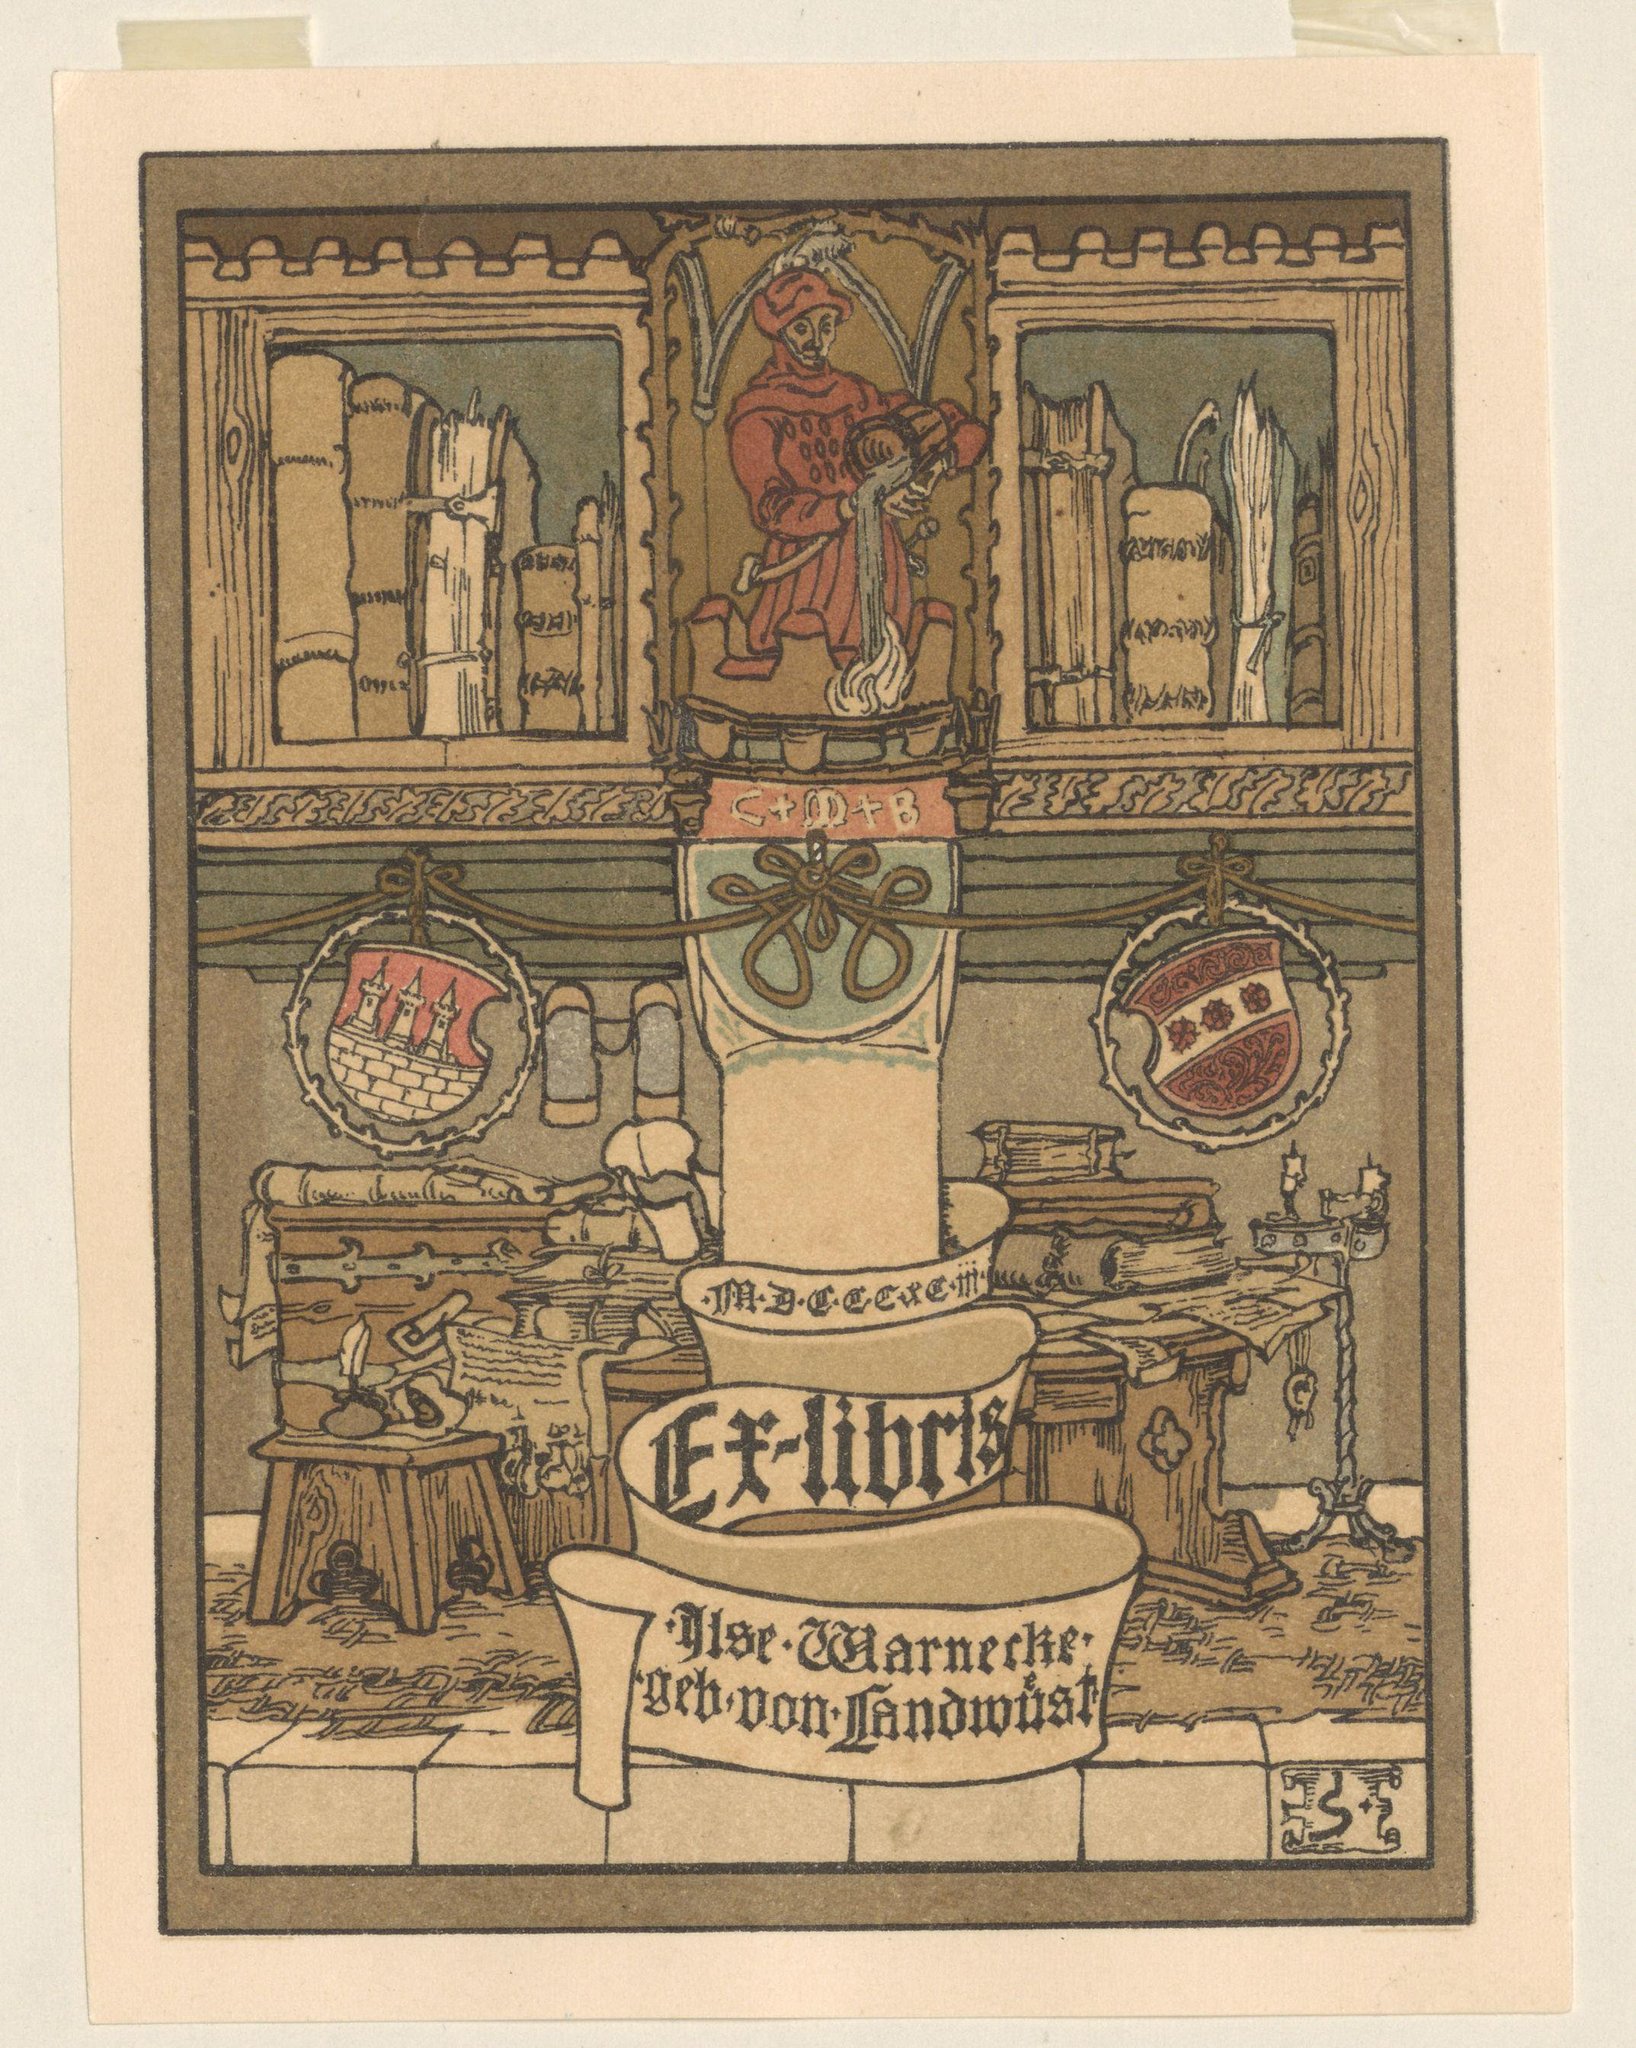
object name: bookplate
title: Ex-libris Ilse Warnecke geb. von Landwüst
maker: joseph sattler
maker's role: painter, print maker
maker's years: 1867-1931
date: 1893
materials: paper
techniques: lithograph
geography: germany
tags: standing figure, pouring, book, armorial bearing, heraldry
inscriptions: date